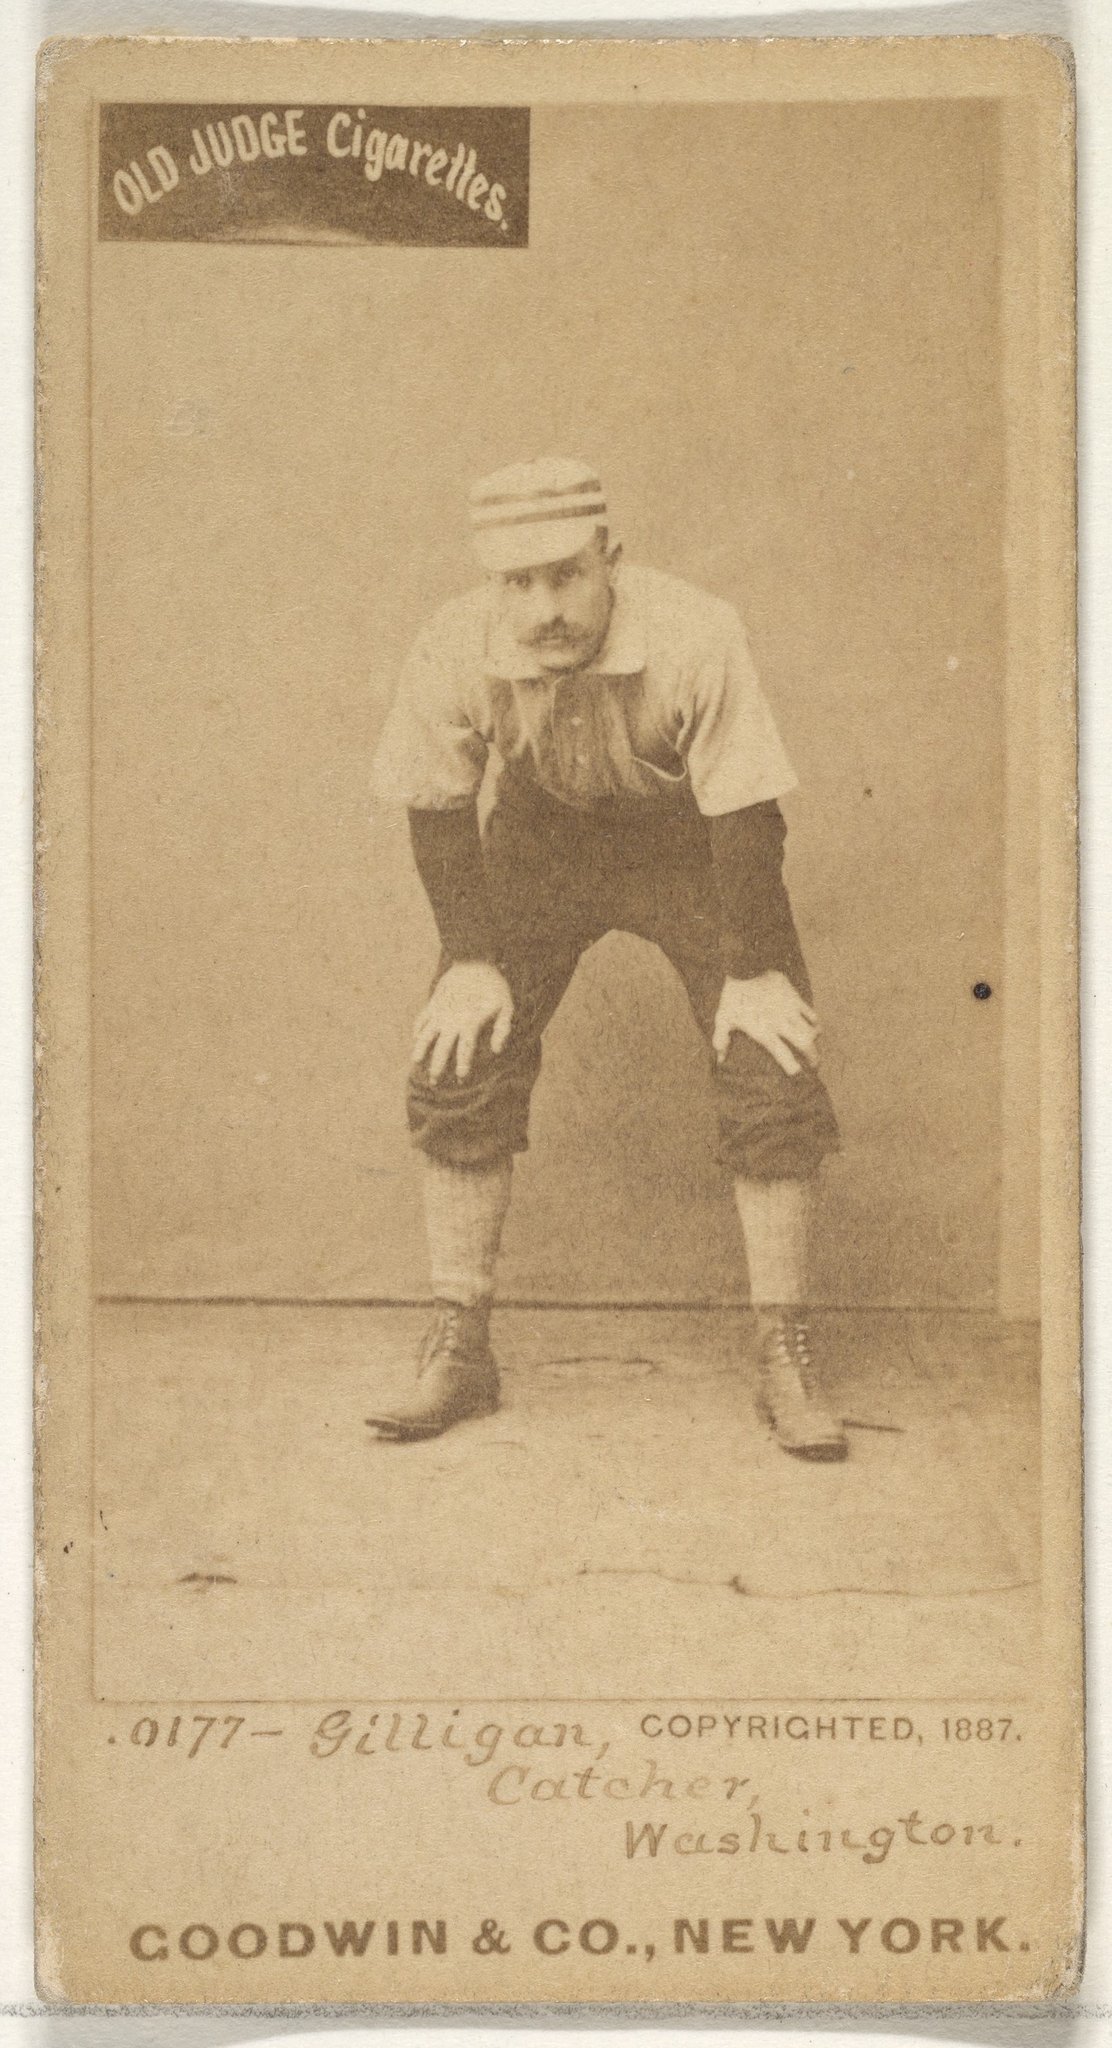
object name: baseball card, photograph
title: Andrew Bernard "Barney" Gilligan, Catcher, Washington Nationals, from the Old Judge series (N172) for Old Judge Cigarettes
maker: goodwin & company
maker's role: publisher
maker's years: 1850-1950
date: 1887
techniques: albumen silver print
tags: men,portraits,baseball